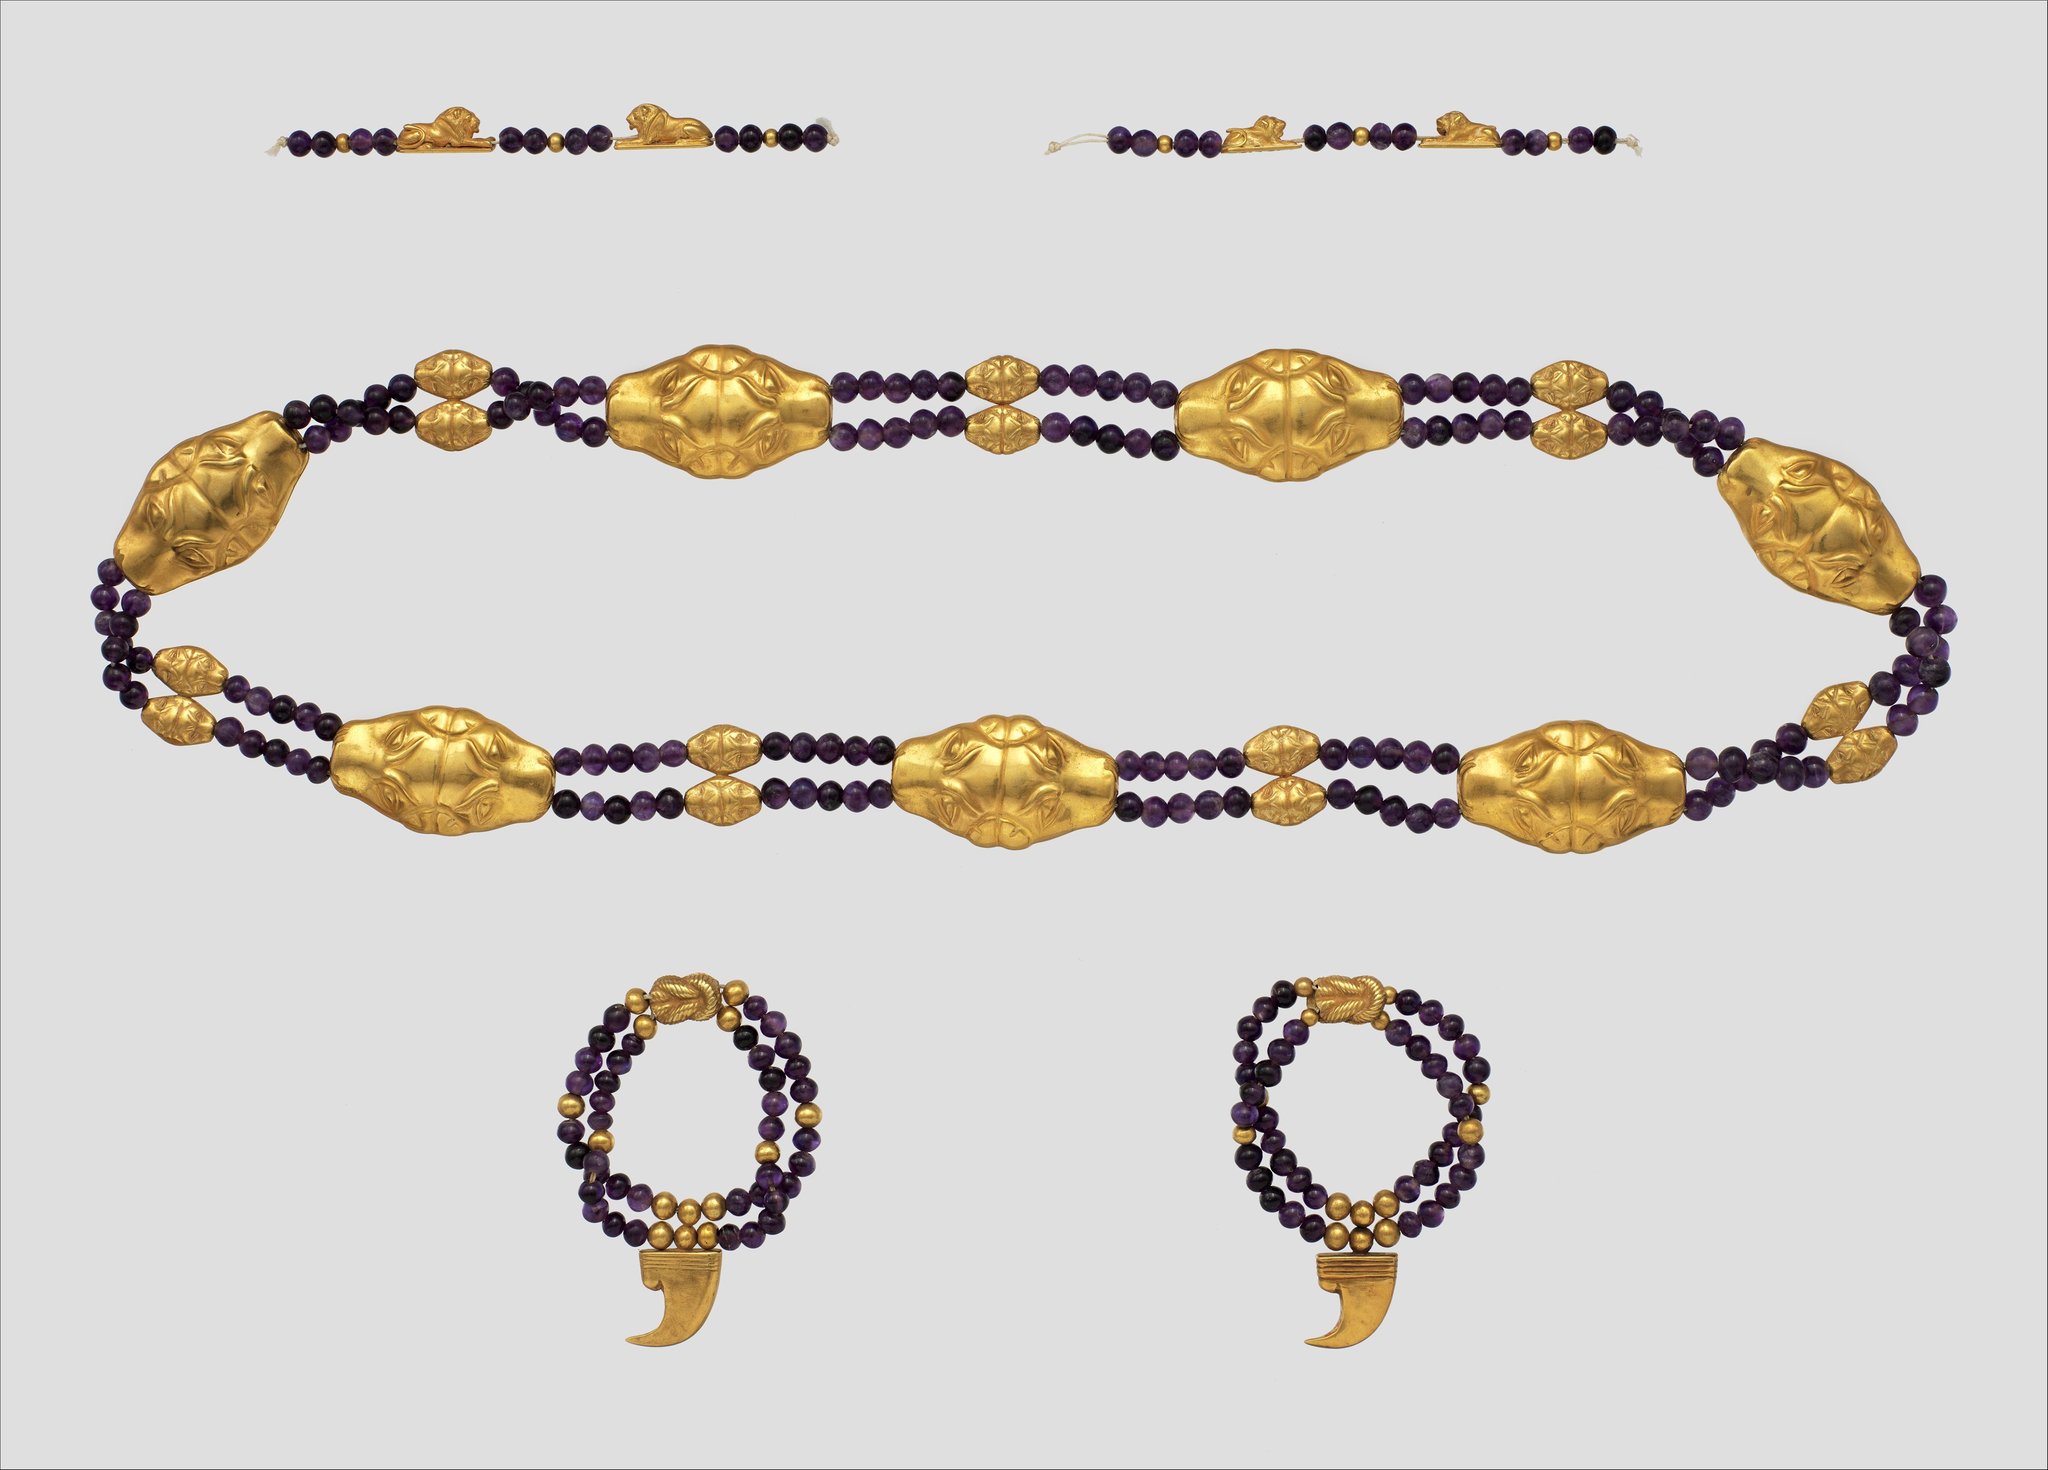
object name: feline headed girdle, anklet, bracelet, sithathoryunet view jewelry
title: Feline-Headed Girdle, Anklets, and Bracelets of Princess Sithathoryunet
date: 1887-1813 BCE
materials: gemstone, gold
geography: egypt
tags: sithathoryunet-jewelry